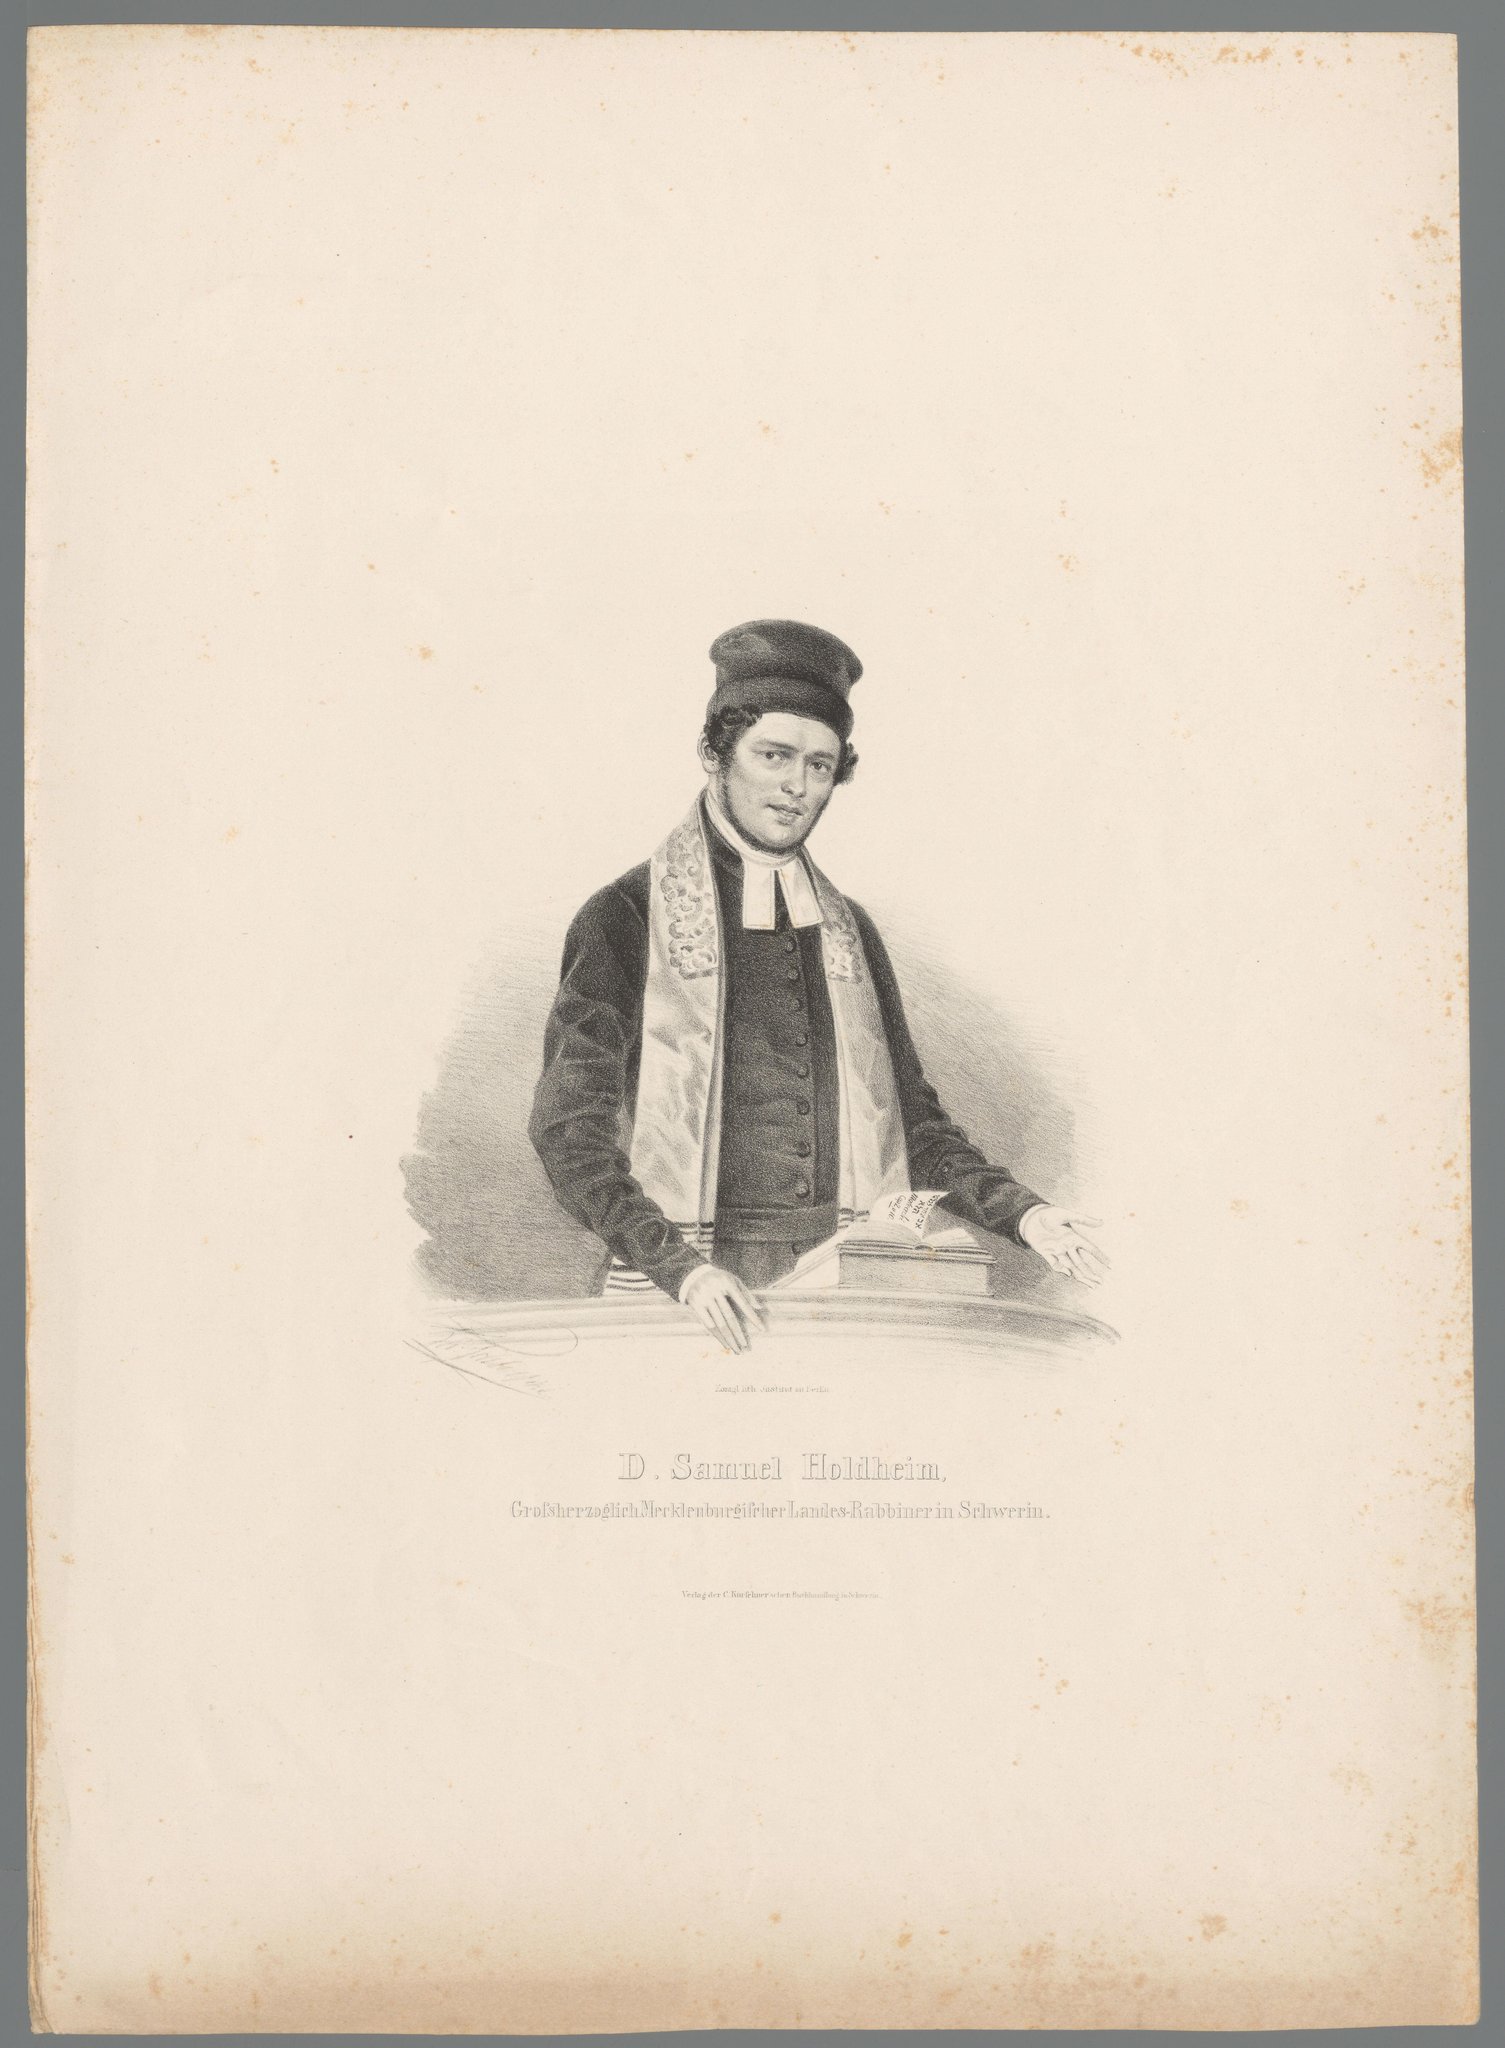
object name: print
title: Portret van Samuel Holdheim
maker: theodor schloepke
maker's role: print maker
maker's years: 1812-1878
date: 1822-1878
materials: paper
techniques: lithograph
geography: schwerin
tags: historical persons, rabbi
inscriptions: collector's mark: Lugt 2228